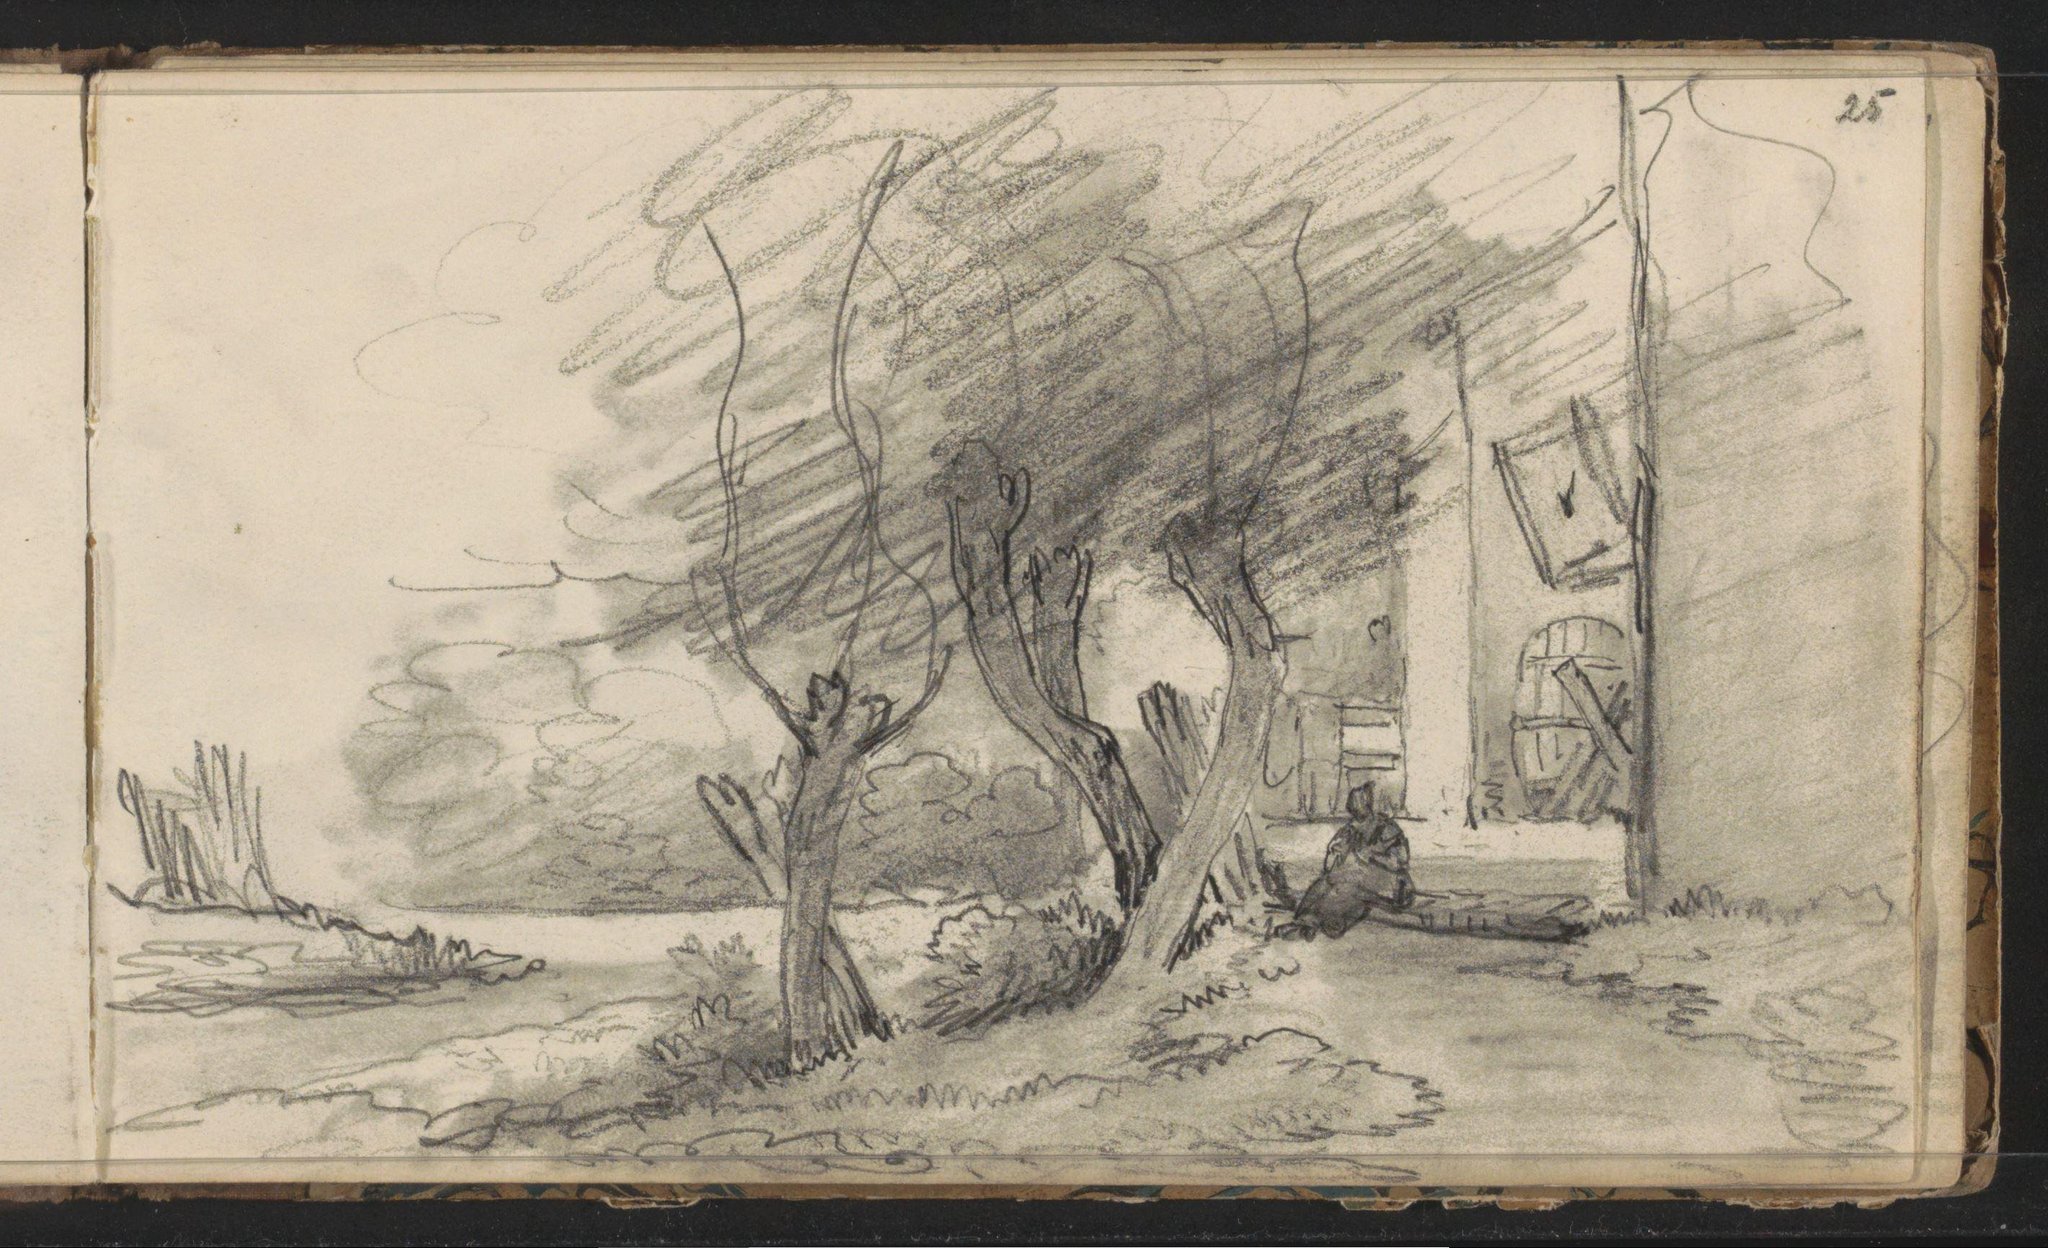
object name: sketchbook leaf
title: Handwerkende vrouw bij een waterkant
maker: arnoldus johannes eymer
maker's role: draughtsman, print maker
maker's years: 1803-1863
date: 1803-1818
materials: paper, pencil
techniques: stumping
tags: sitting figure - aa - female human figure, landscapes with waters, waterscapes, seascapes (in the temperate zone) (+ landscape with figures, staffage), home sewing; repair of clothes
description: De vrouw zit op een stoep tussen twee huizen. Bladzijde 25 uit een schetsboek met 74 bladzijden.